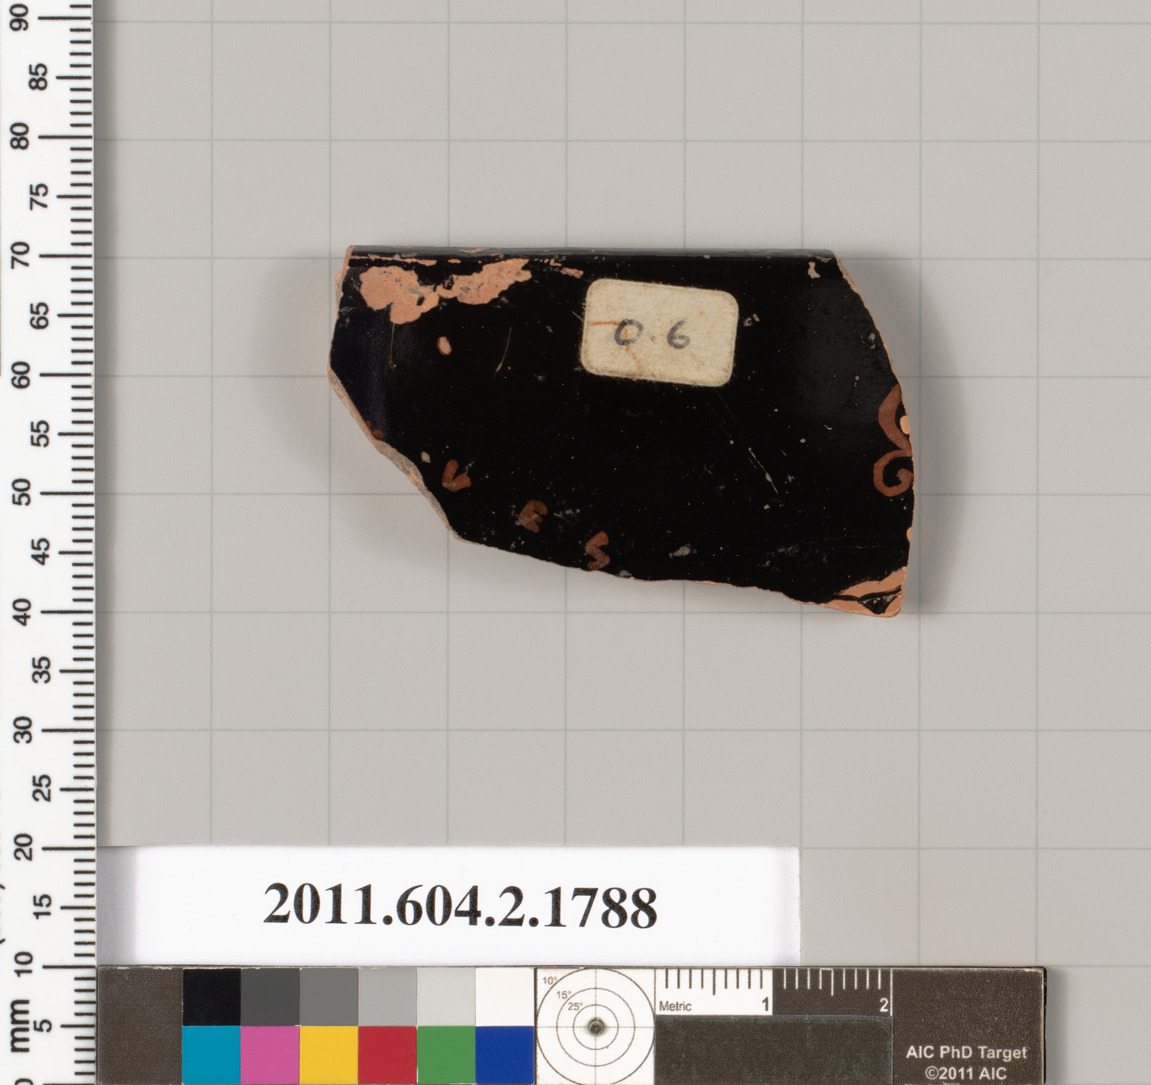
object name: skyphos fragment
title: Terracotta rim fragment of a skyphos (deep drinking cup)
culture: greek, attic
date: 475-451 BCE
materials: terracotta